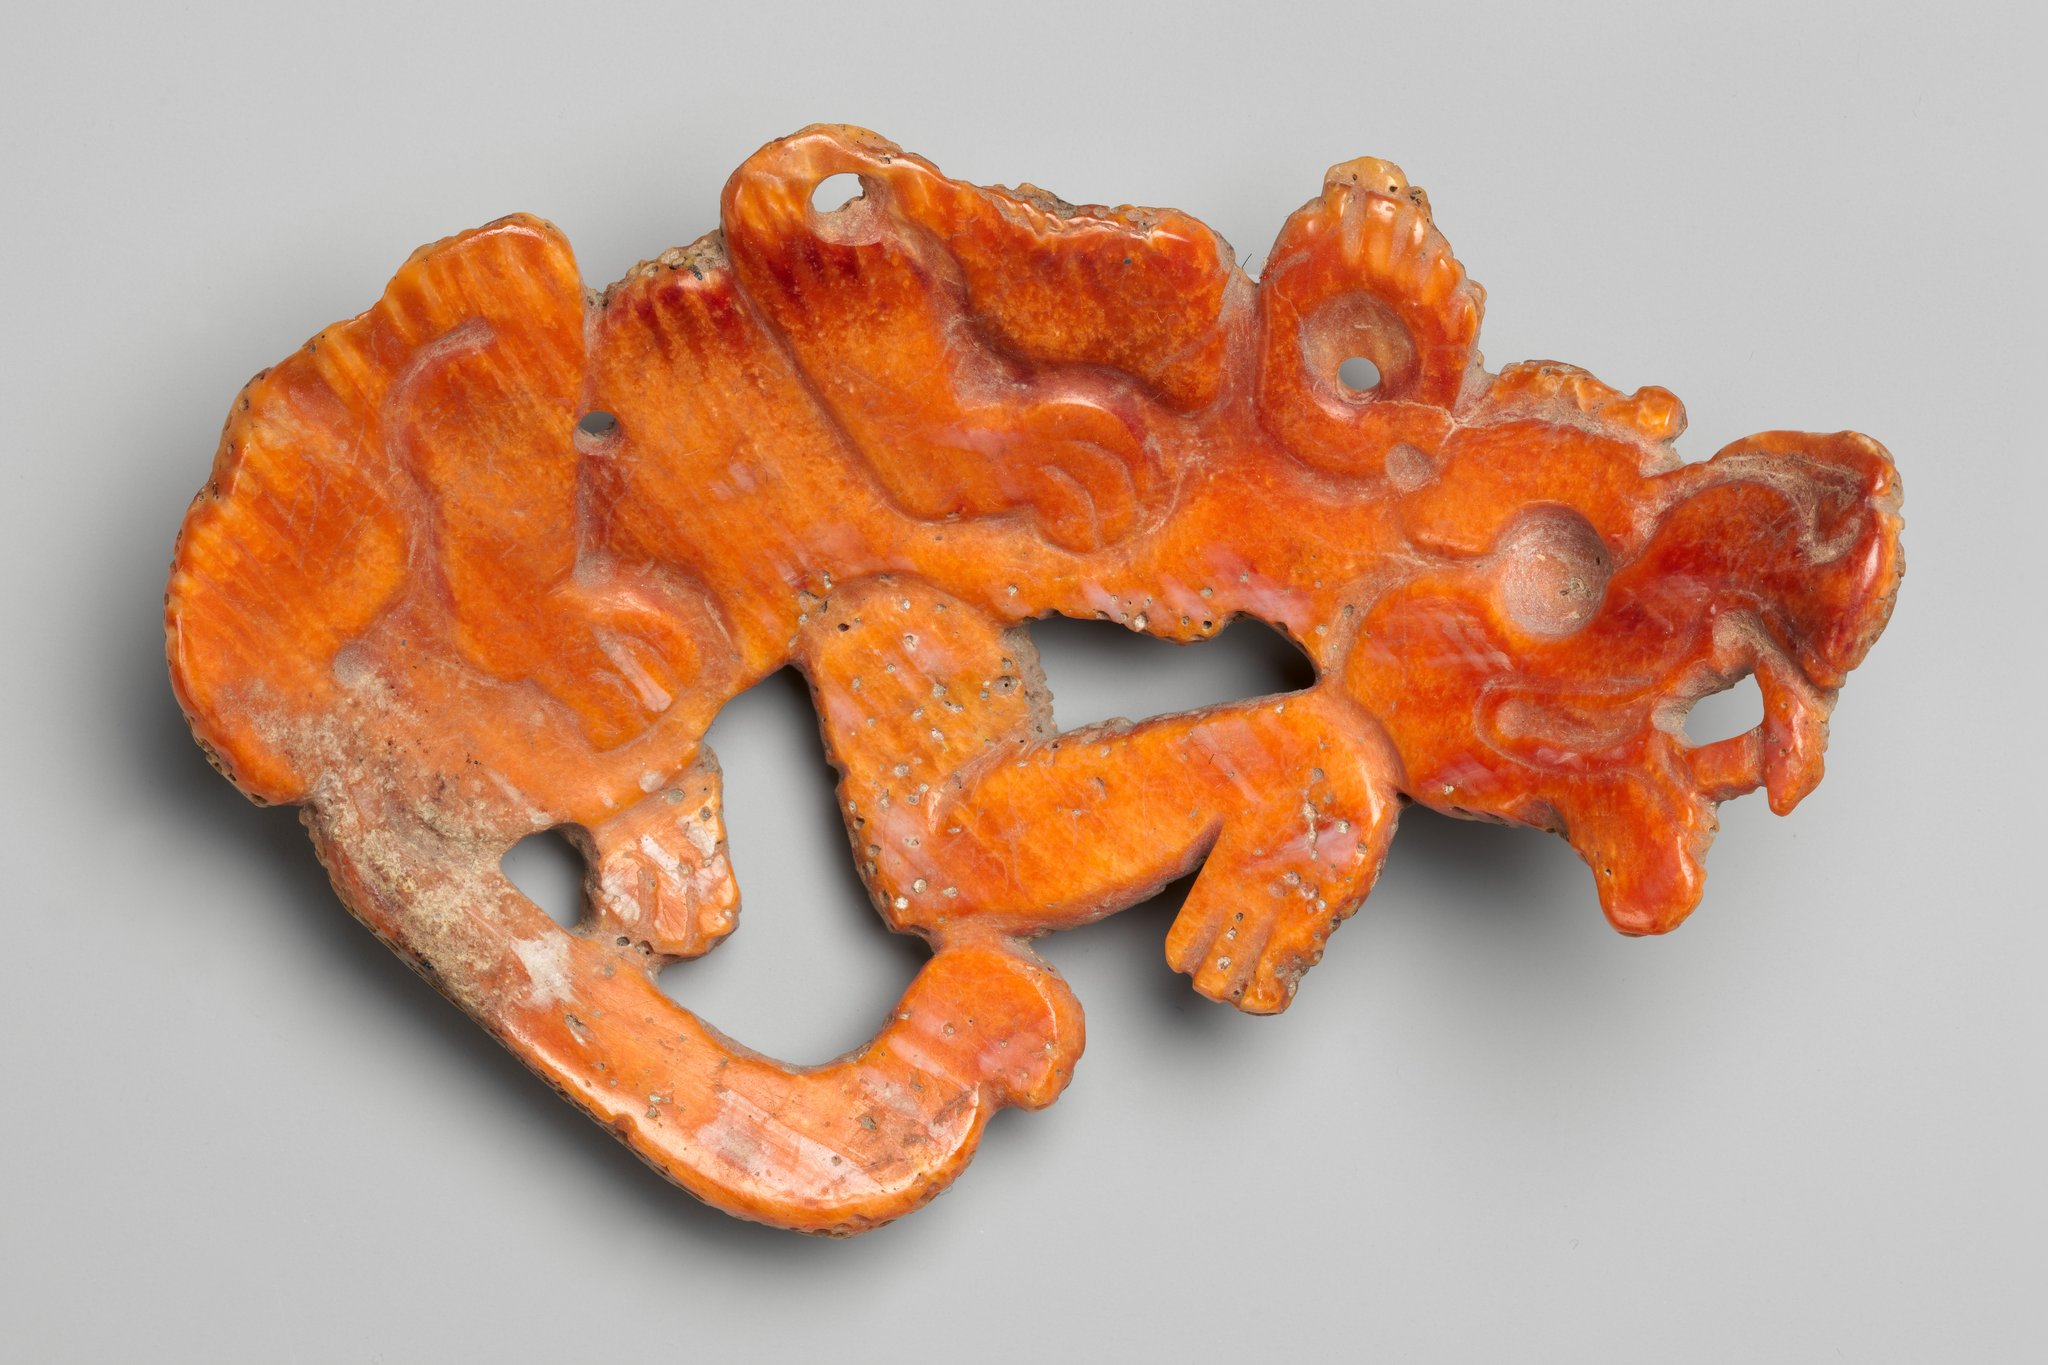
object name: ornament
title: Ornament in the shape of a mammal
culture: maya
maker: maya artist(s)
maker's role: artist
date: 600-800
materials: shell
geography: guatemala or mexico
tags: dogs